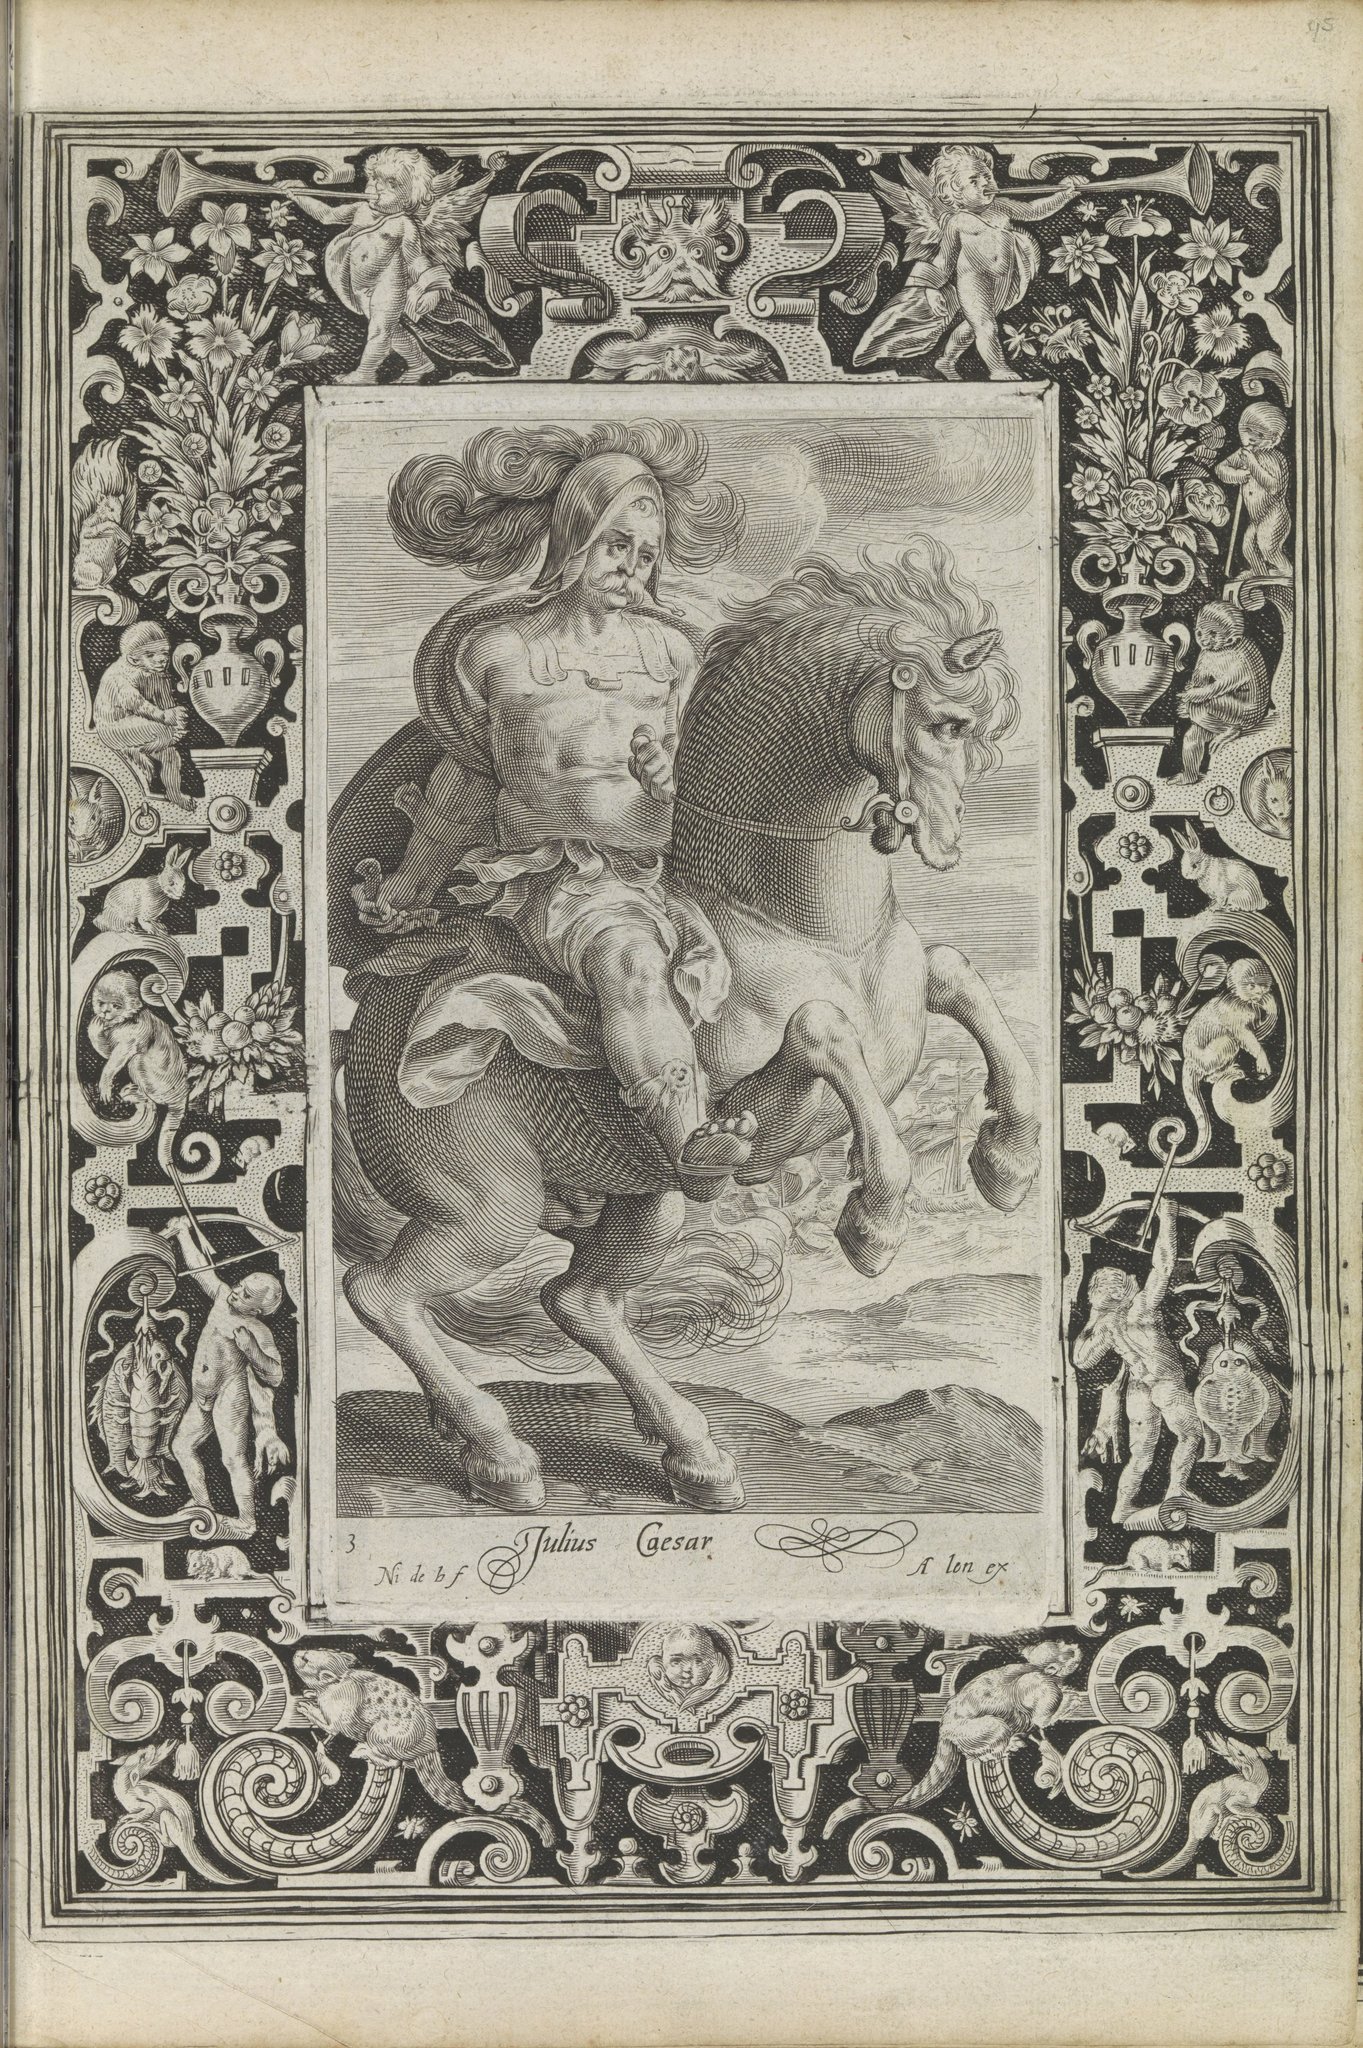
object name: album leaf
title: Julius Caesar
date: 1582-1635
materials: paper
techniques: engraving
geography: low countries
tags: julius caesar (one of the nine worthies), frequently used ornamental compositions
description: Julius Caesar, een beroemde veldheer uit de Oudheid, te paard in een landschap. Hij maakt deel uit van De Negen Besten. Onder de voorstelling een vers in het Latijn. De voorstelling is gevat in een omlijsting met krulornamenten en verschillende dieren zoals een kat die naar een muis loert, apen en konijnen waarop twee jongens jagen. Deze prent maakt deel uit van een album.